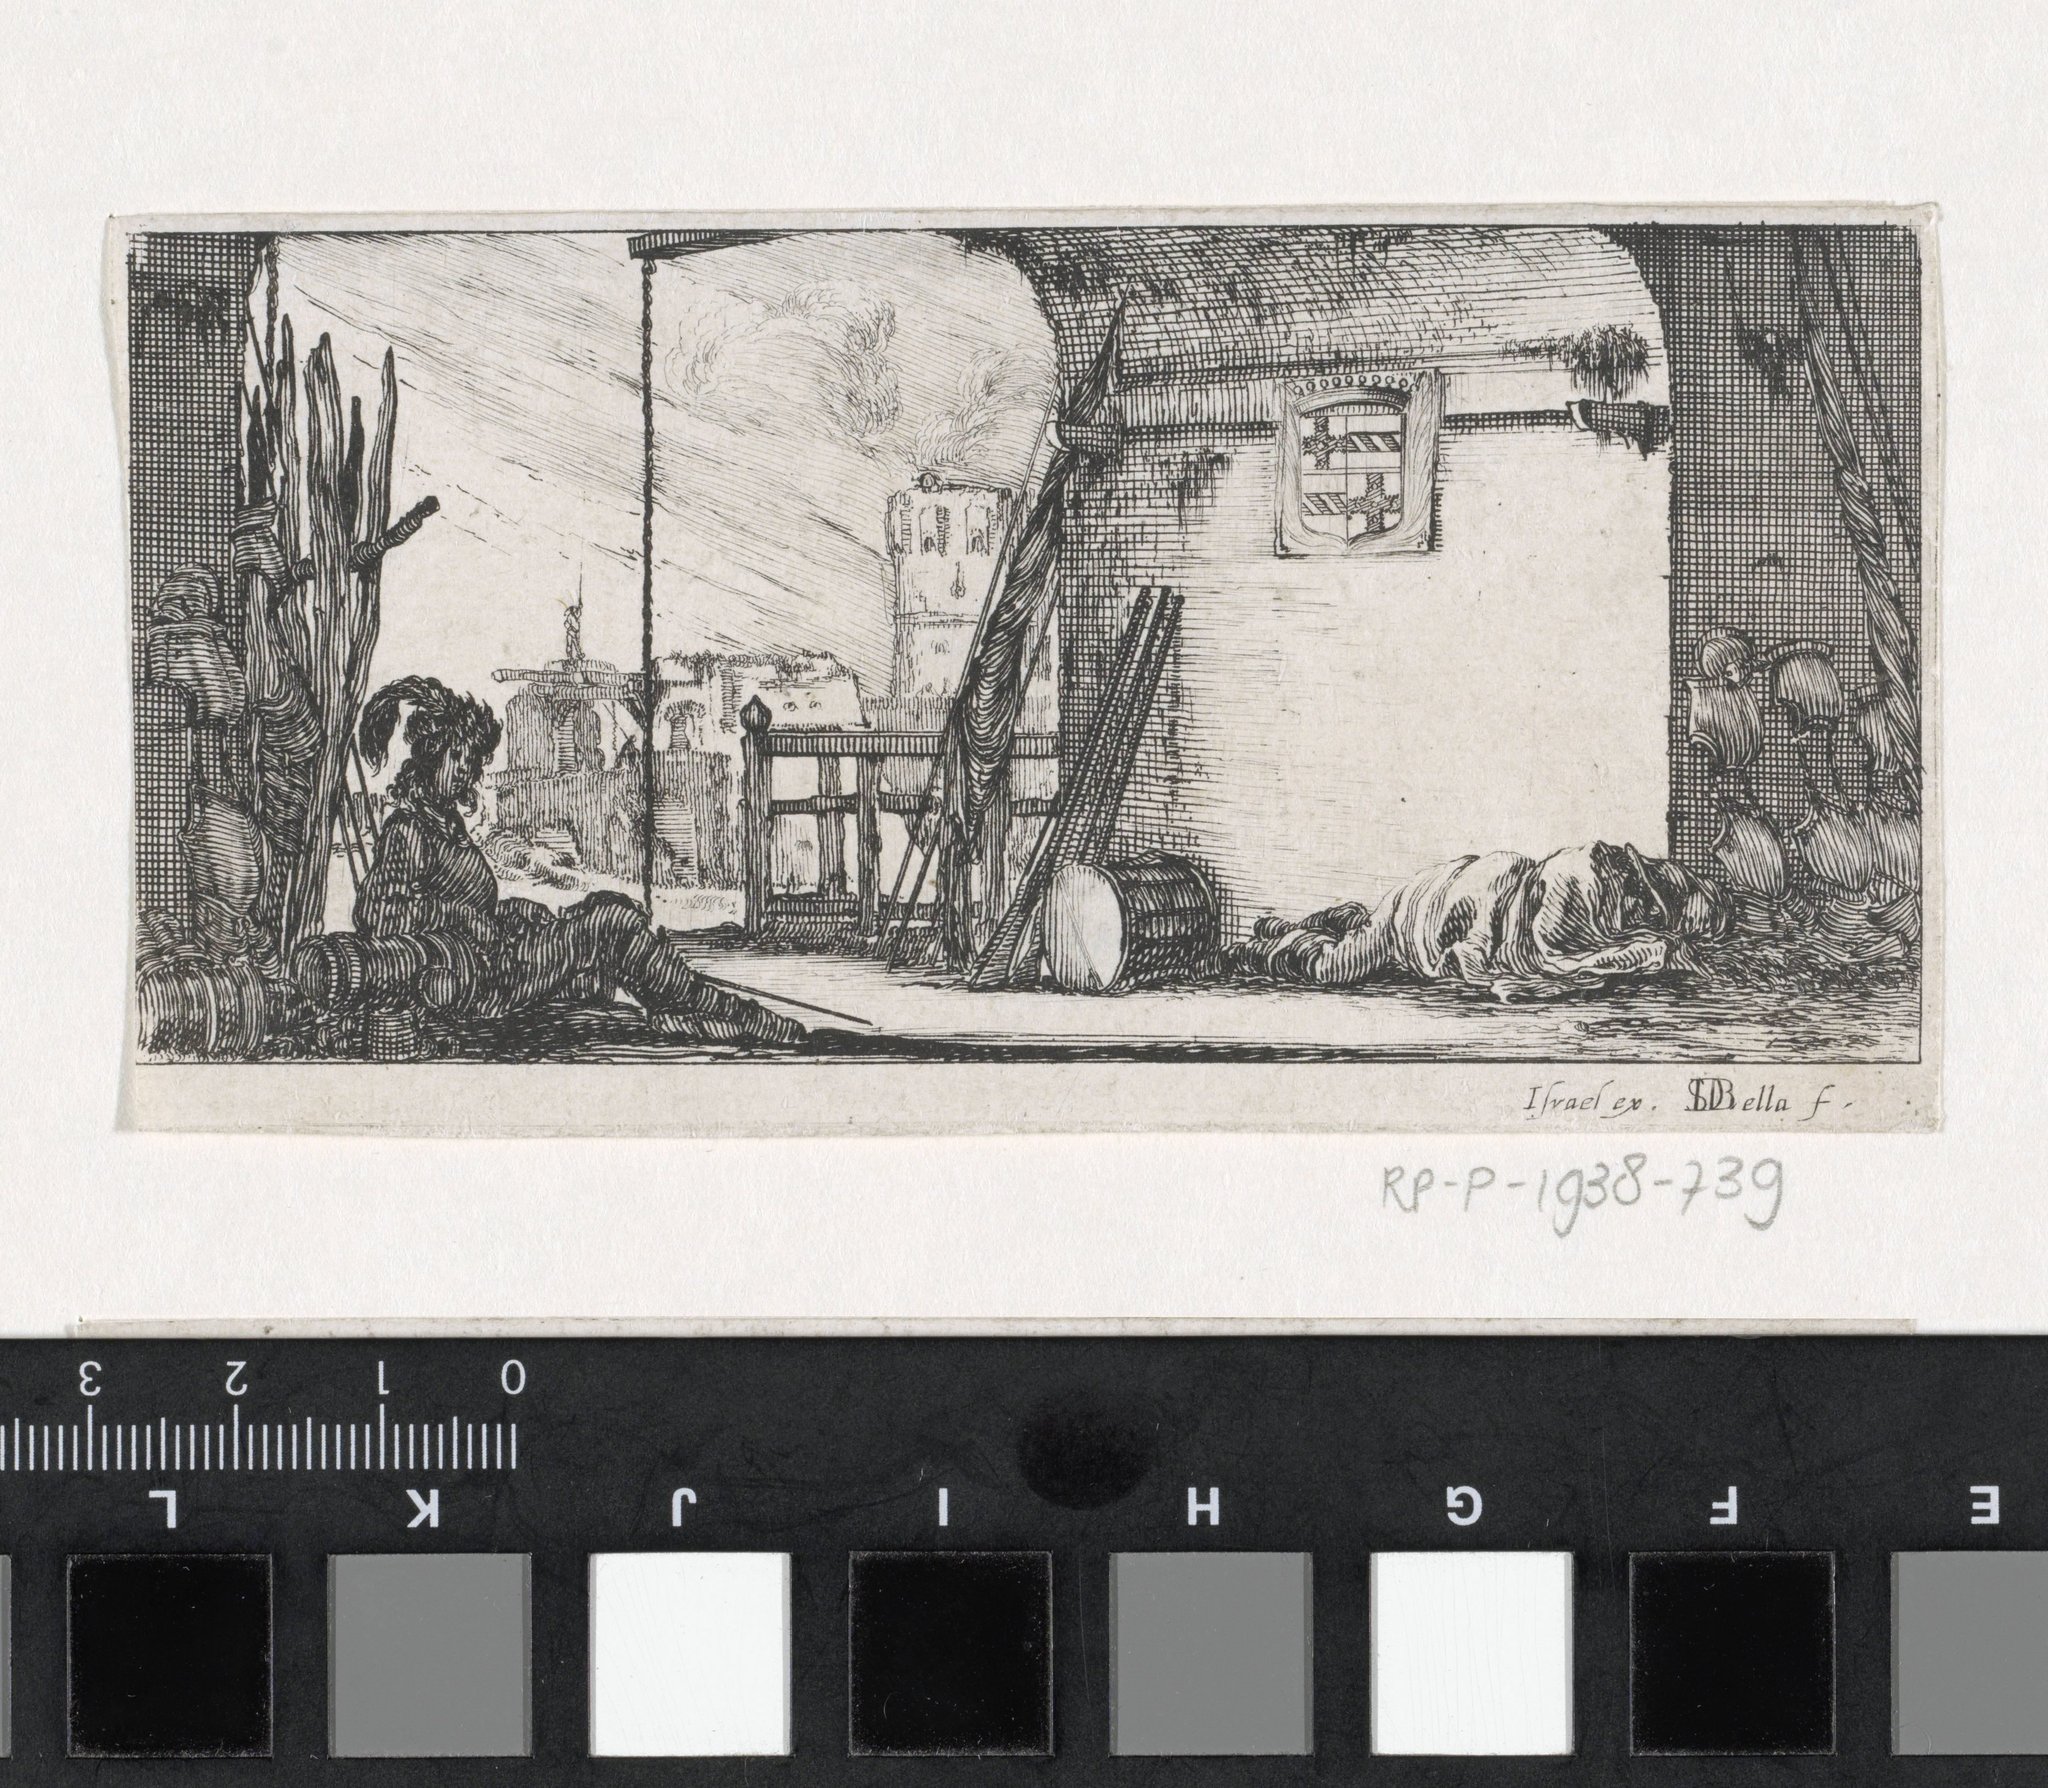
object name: print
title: Desseins de quelques conduites de troupes, canons, et ataques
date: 1620-1664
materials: paper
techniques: etching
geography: paris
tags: fortress, guard duty, keeping sentry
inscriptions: collector's mark: Lugt 2228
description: De gewelfde ingang van een fort waar de wacht wordt gehouden door een zittende soldaat. Een tweede soldaat ligt op de grond te slapen. Op de muur rechts het wapen van Henri Roger du Plessis-Liancourt. Op de achtergrond enkele ruïnes.